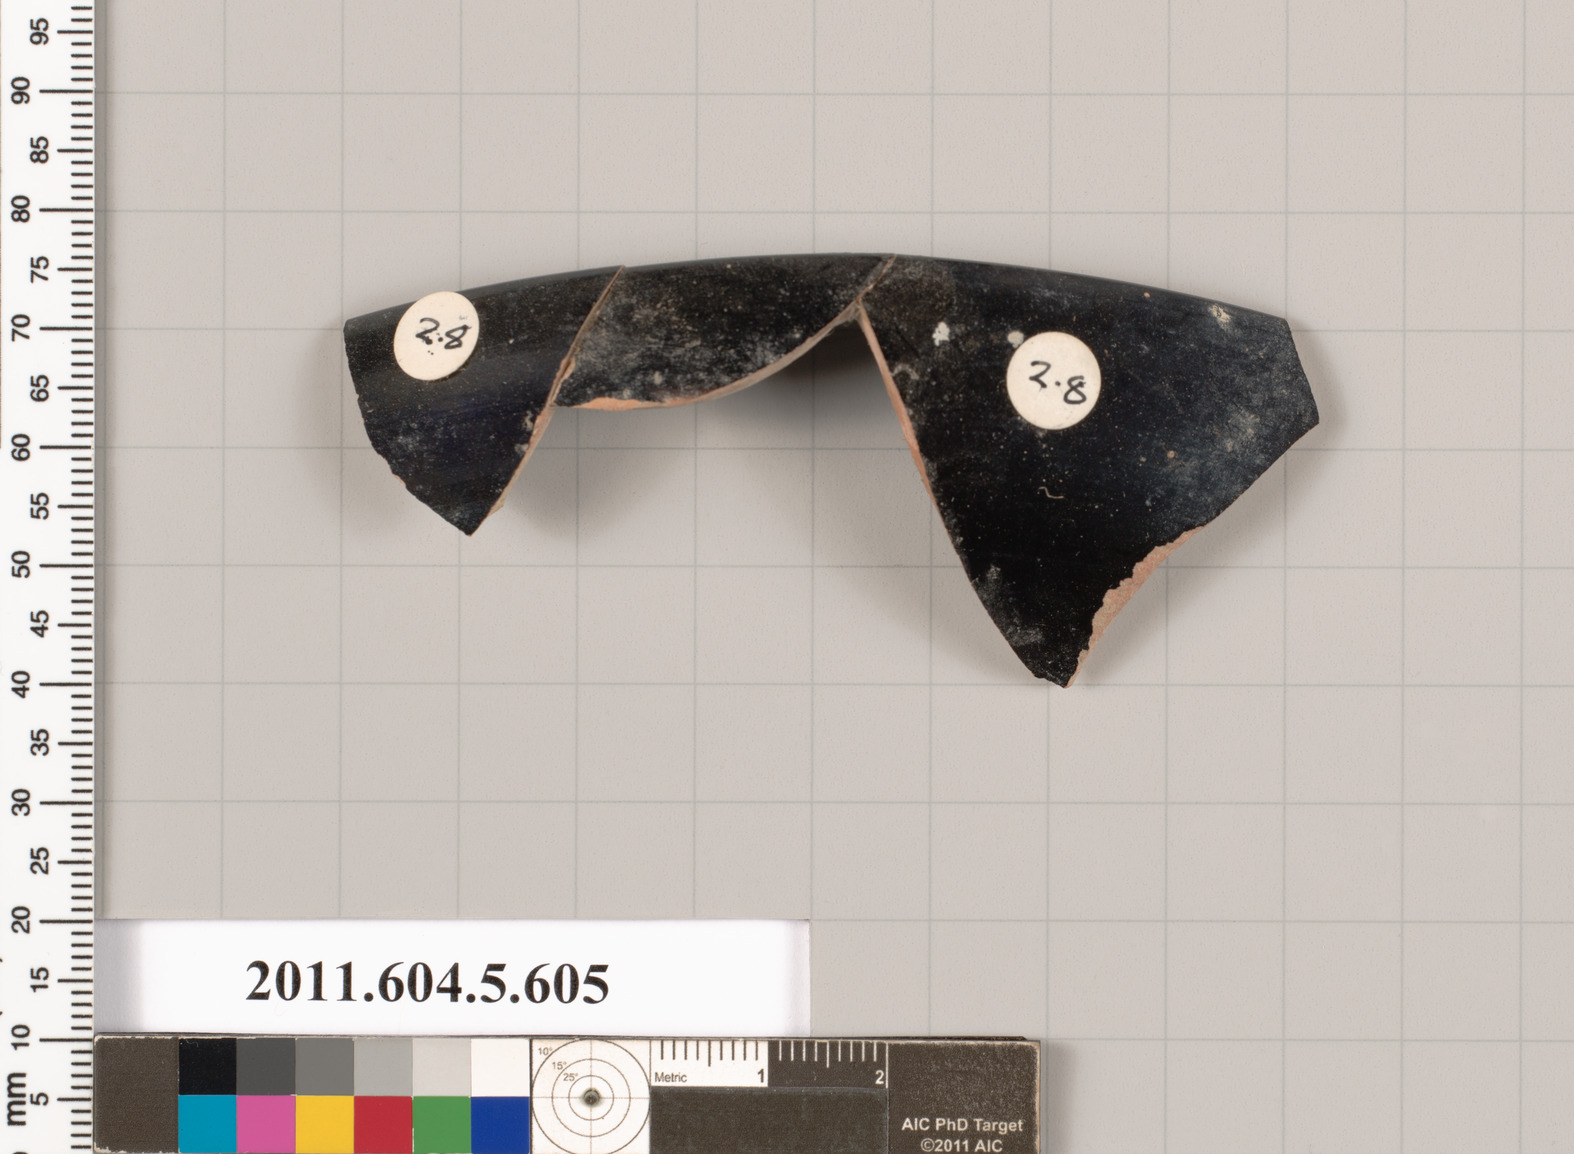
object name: kylix fragment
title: Terracotta fragment of a kylix (drinking cup)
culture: greek, attic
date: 600-401 BCE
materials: terracotta